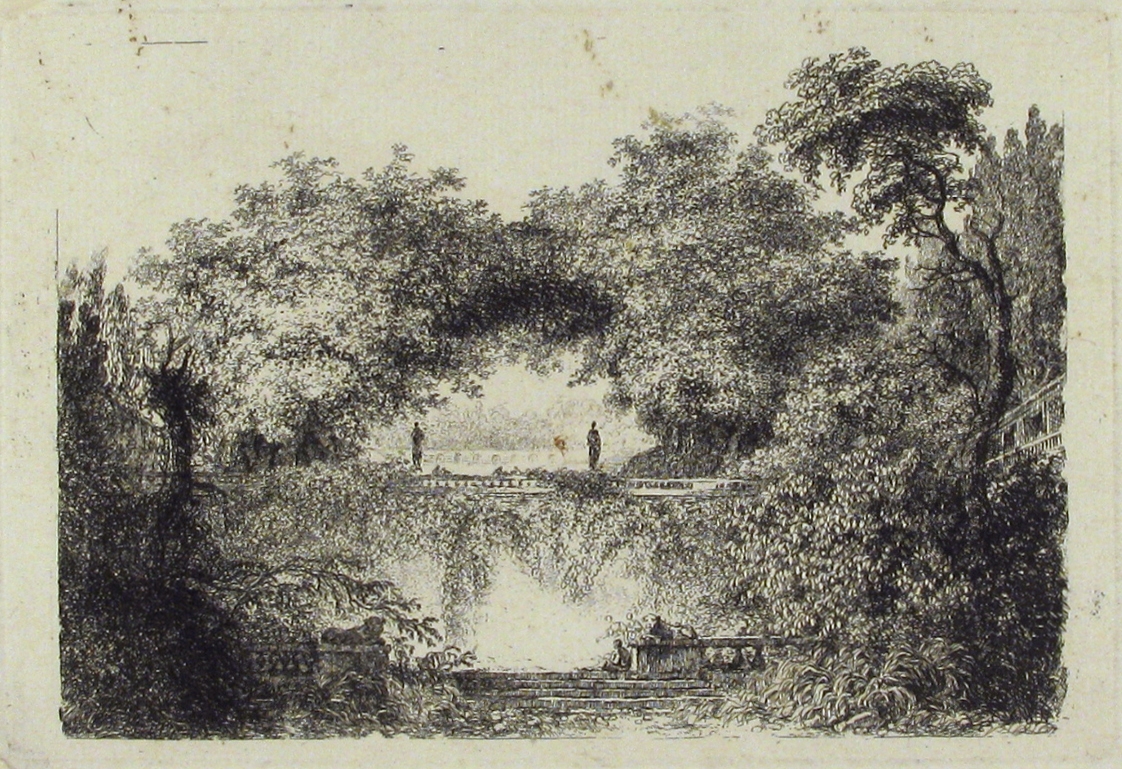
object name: print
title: Le Petit Parc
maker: jean claude richard, abbé de saint-non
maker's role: artist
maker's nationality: french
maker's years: 1727-1791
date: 1701-1800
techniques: etching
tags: trees